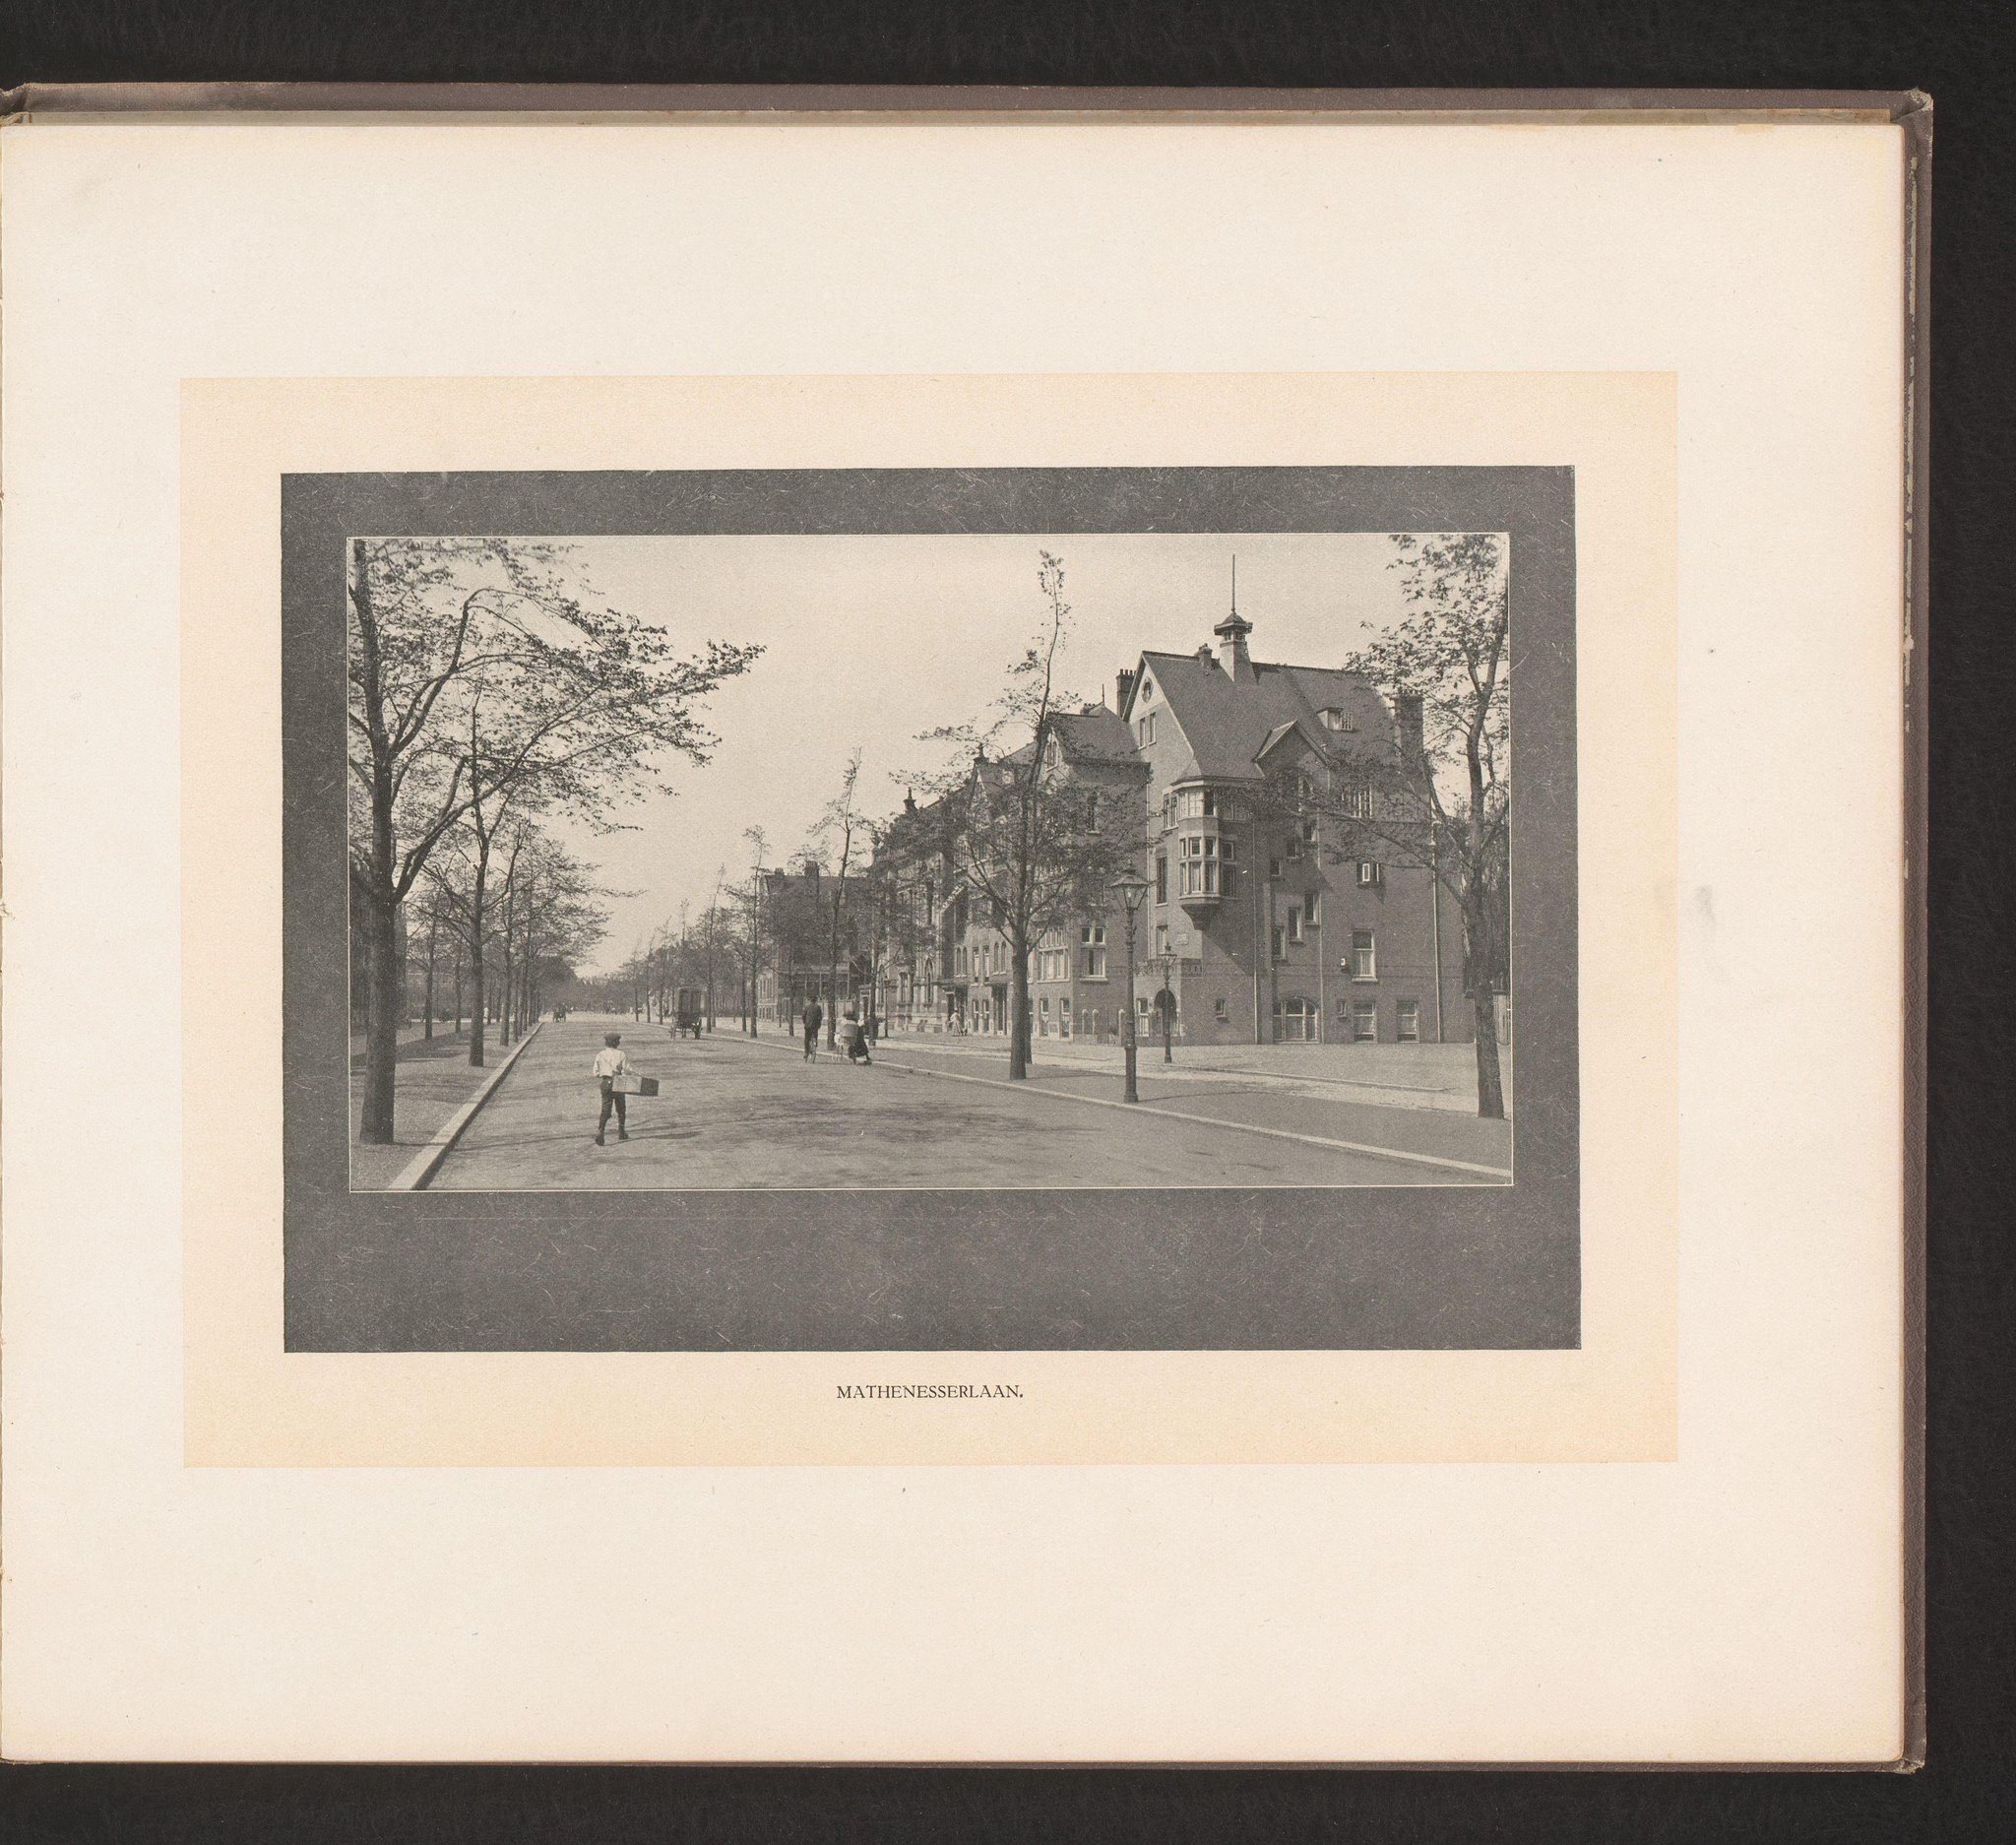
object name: album leaf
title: Gezicht op de Mathenesserlaan te Rotterdam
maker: Anonymous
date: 1908-1913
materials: paper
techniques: autotype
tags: street (+ city(-scape) with figures, staffage), rotterdam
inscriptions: inscription: ‘Mathenesserlaan’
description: Deze prent maakt deel uit van een album.